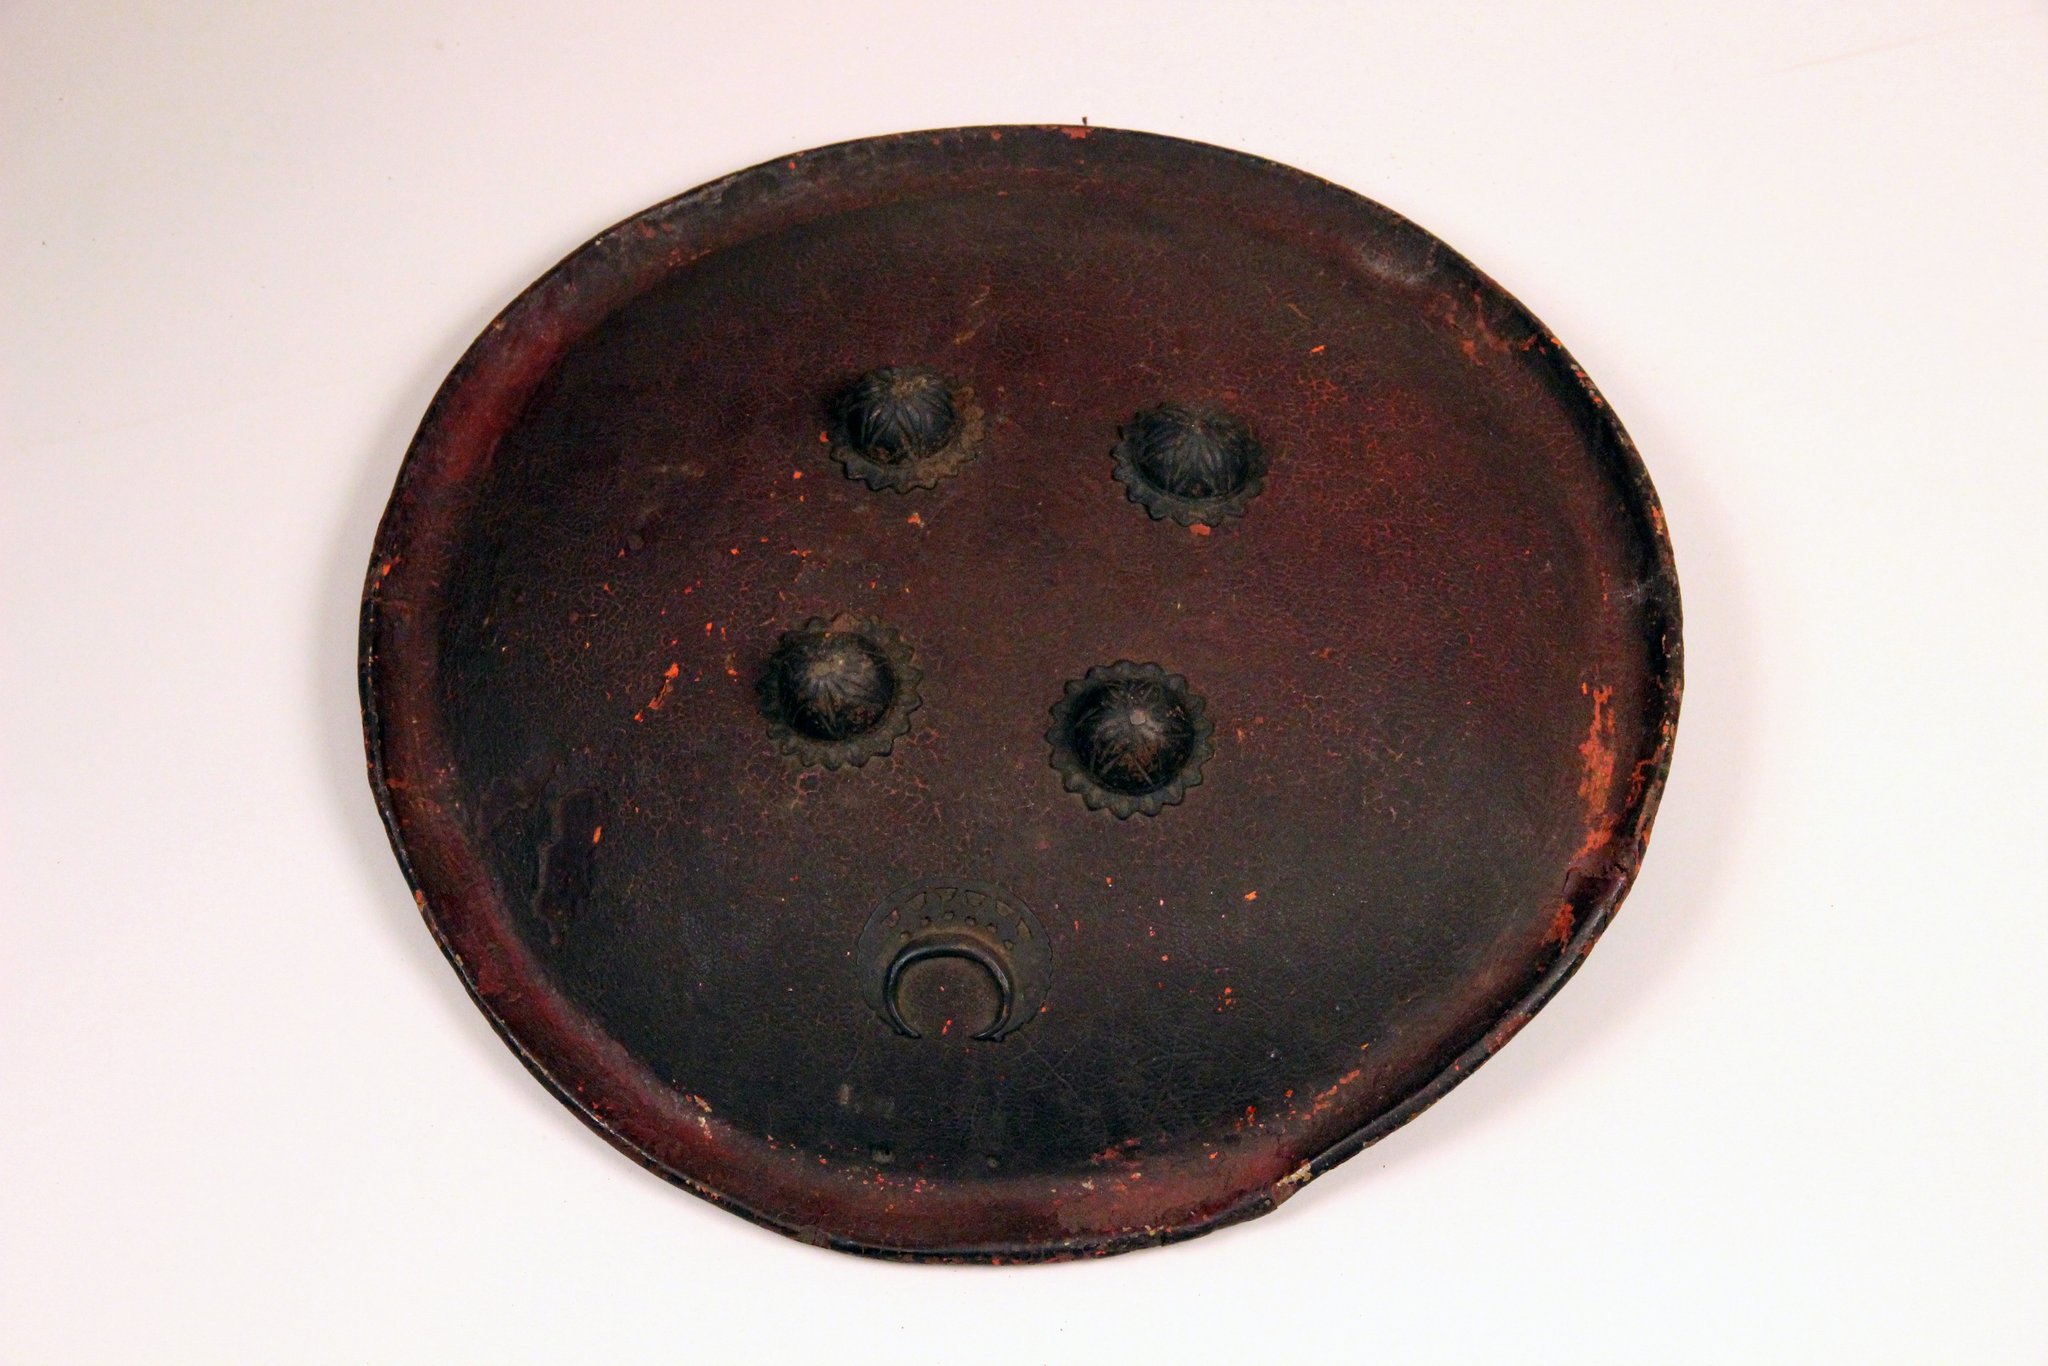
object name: shield dhàl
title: Shield (Dhàl)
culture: indian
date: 1801-1900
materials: iron, lacquer, leather, textile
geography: india